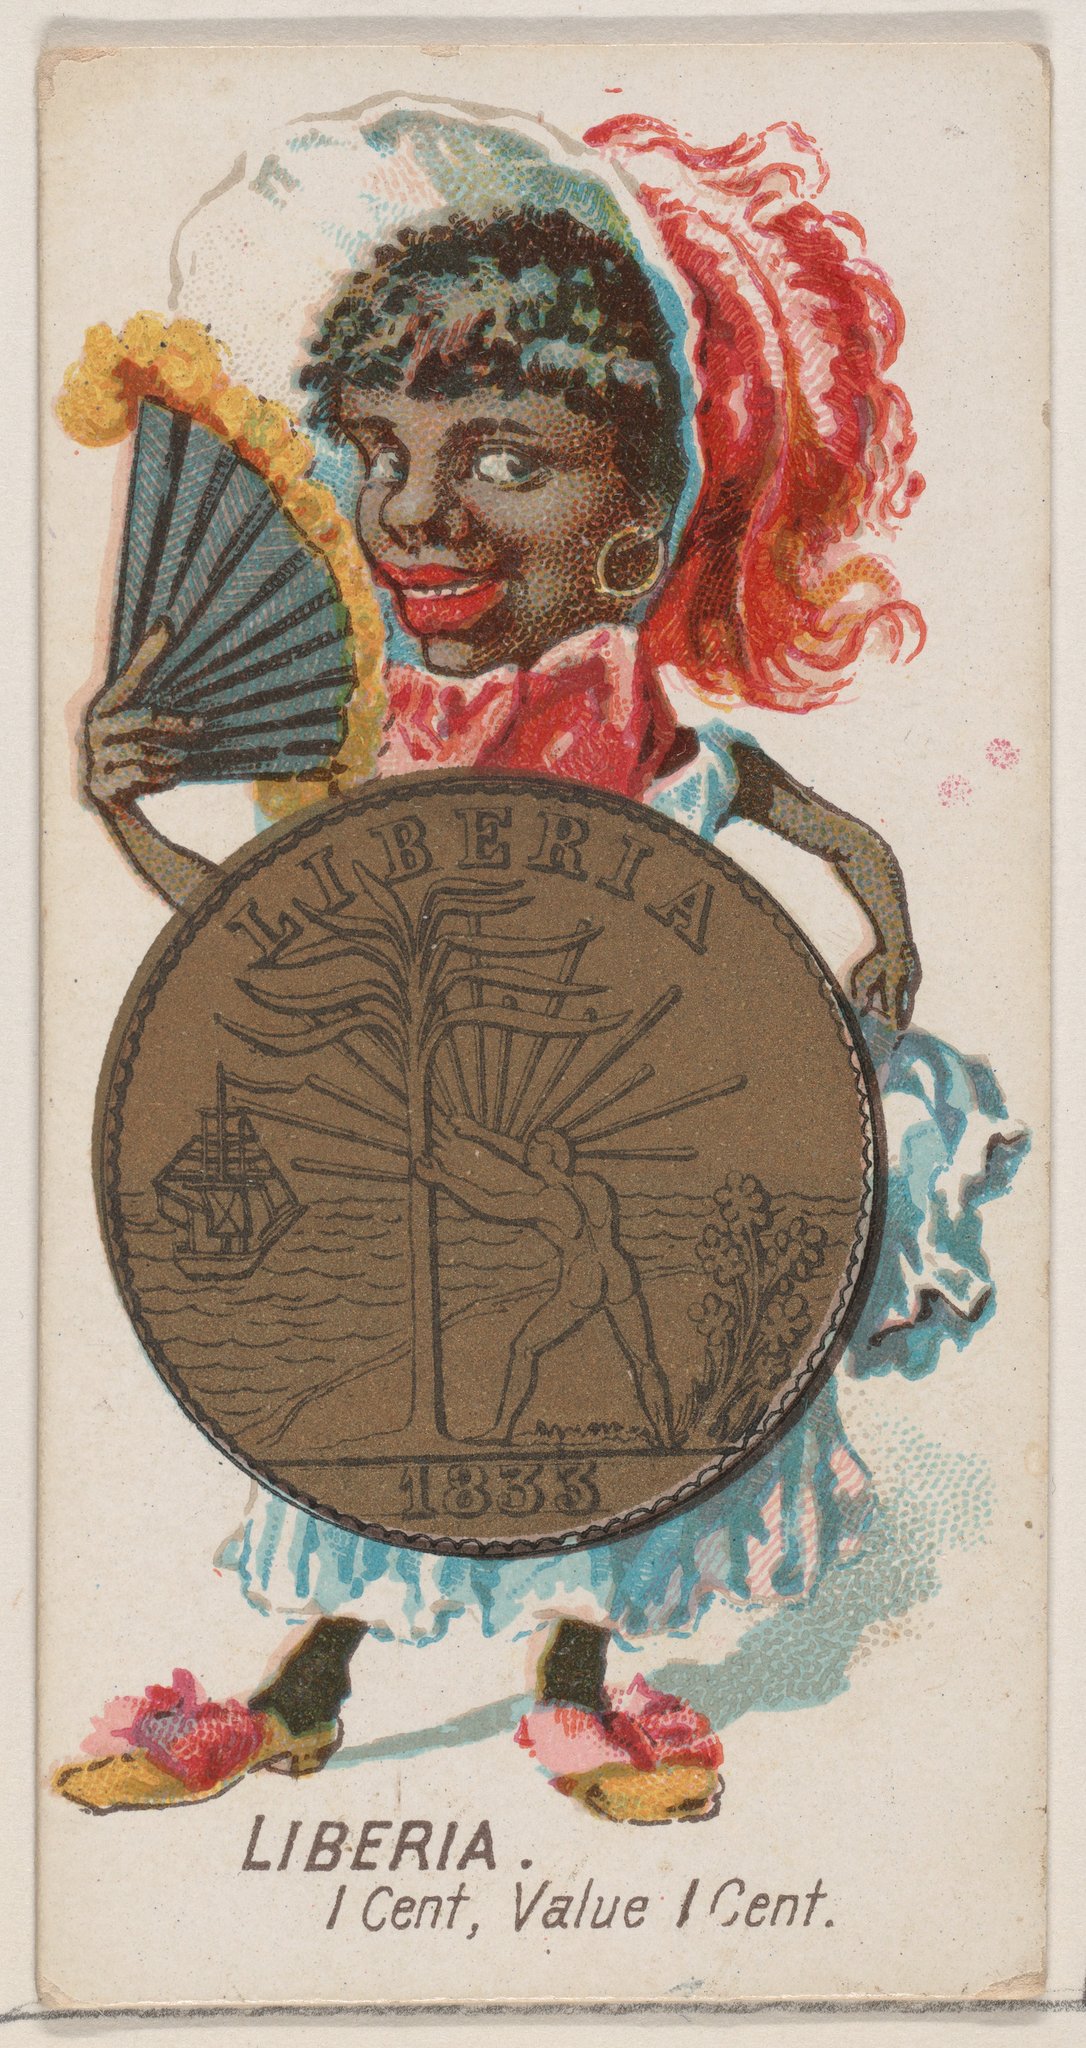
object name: print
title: Caricatured Liberian, 1 Cent, from the series Coins of All Nations (N72, variation 1) for Duke brand cigarettes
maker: w. duke, sons & co.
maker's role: publisher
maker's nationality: american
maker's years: 1870-1920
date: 1889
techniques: color lithograph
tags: women,coins